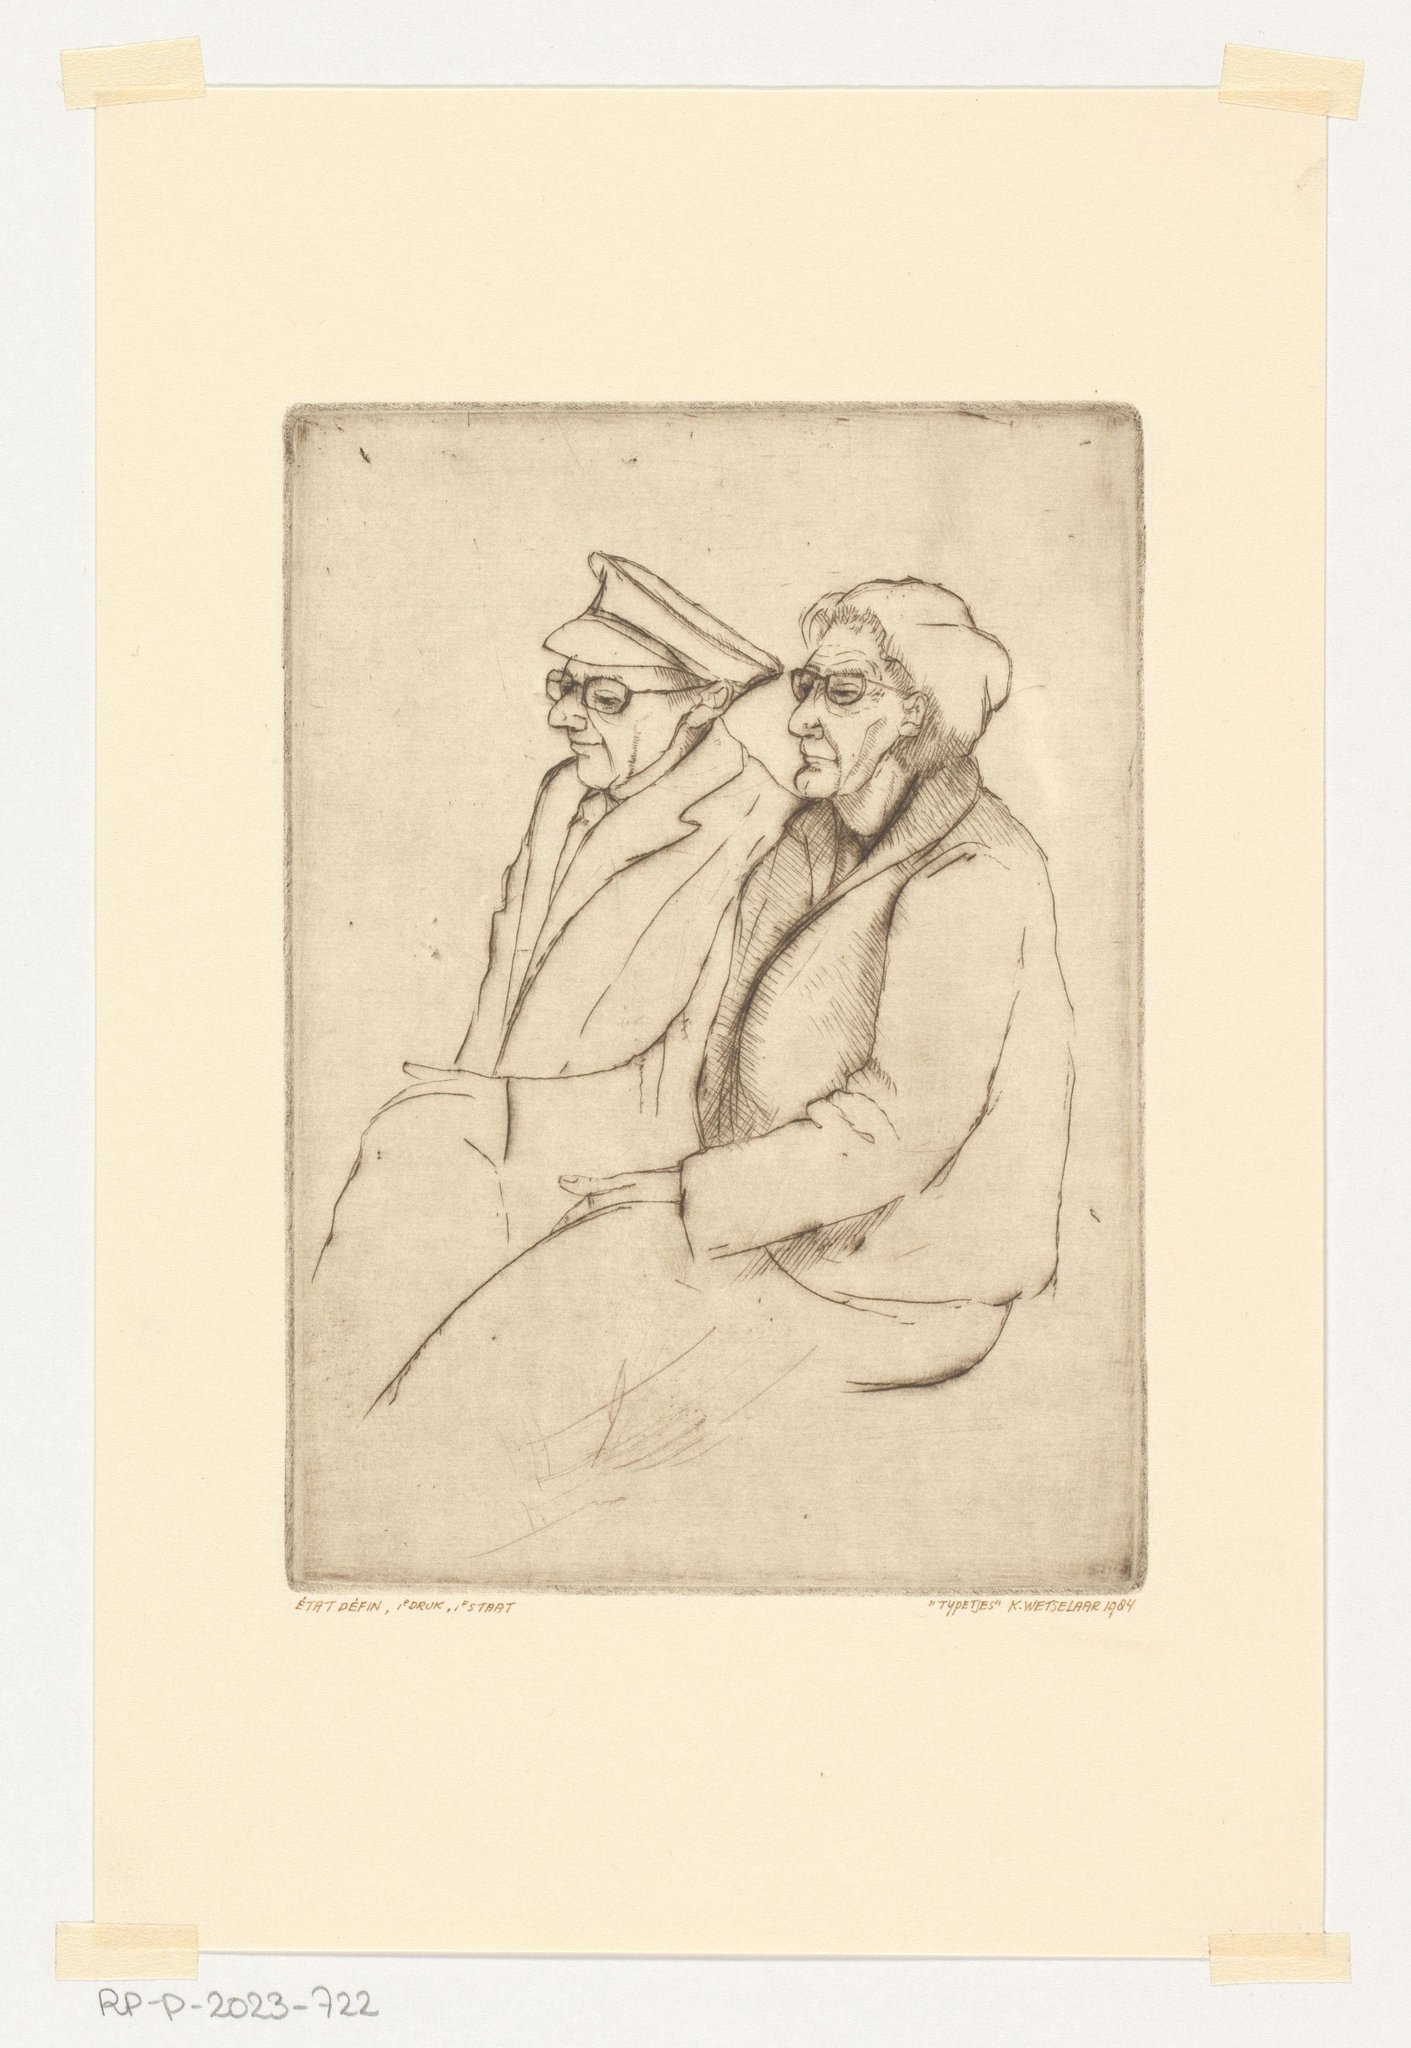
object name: print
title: Typetjes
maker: karel wetselaar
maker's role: print maker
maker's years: 1935-2017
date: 1984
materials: paper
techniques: drypoint, etching, intaglio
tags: eyeglasses, spectacles, head-gear, anonymous historical persons portrayed in a double portrait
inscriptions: signature and date: ‘K. Wetselaar 1984’, inscription: ‘état défin, 1e druk, 1e staat’